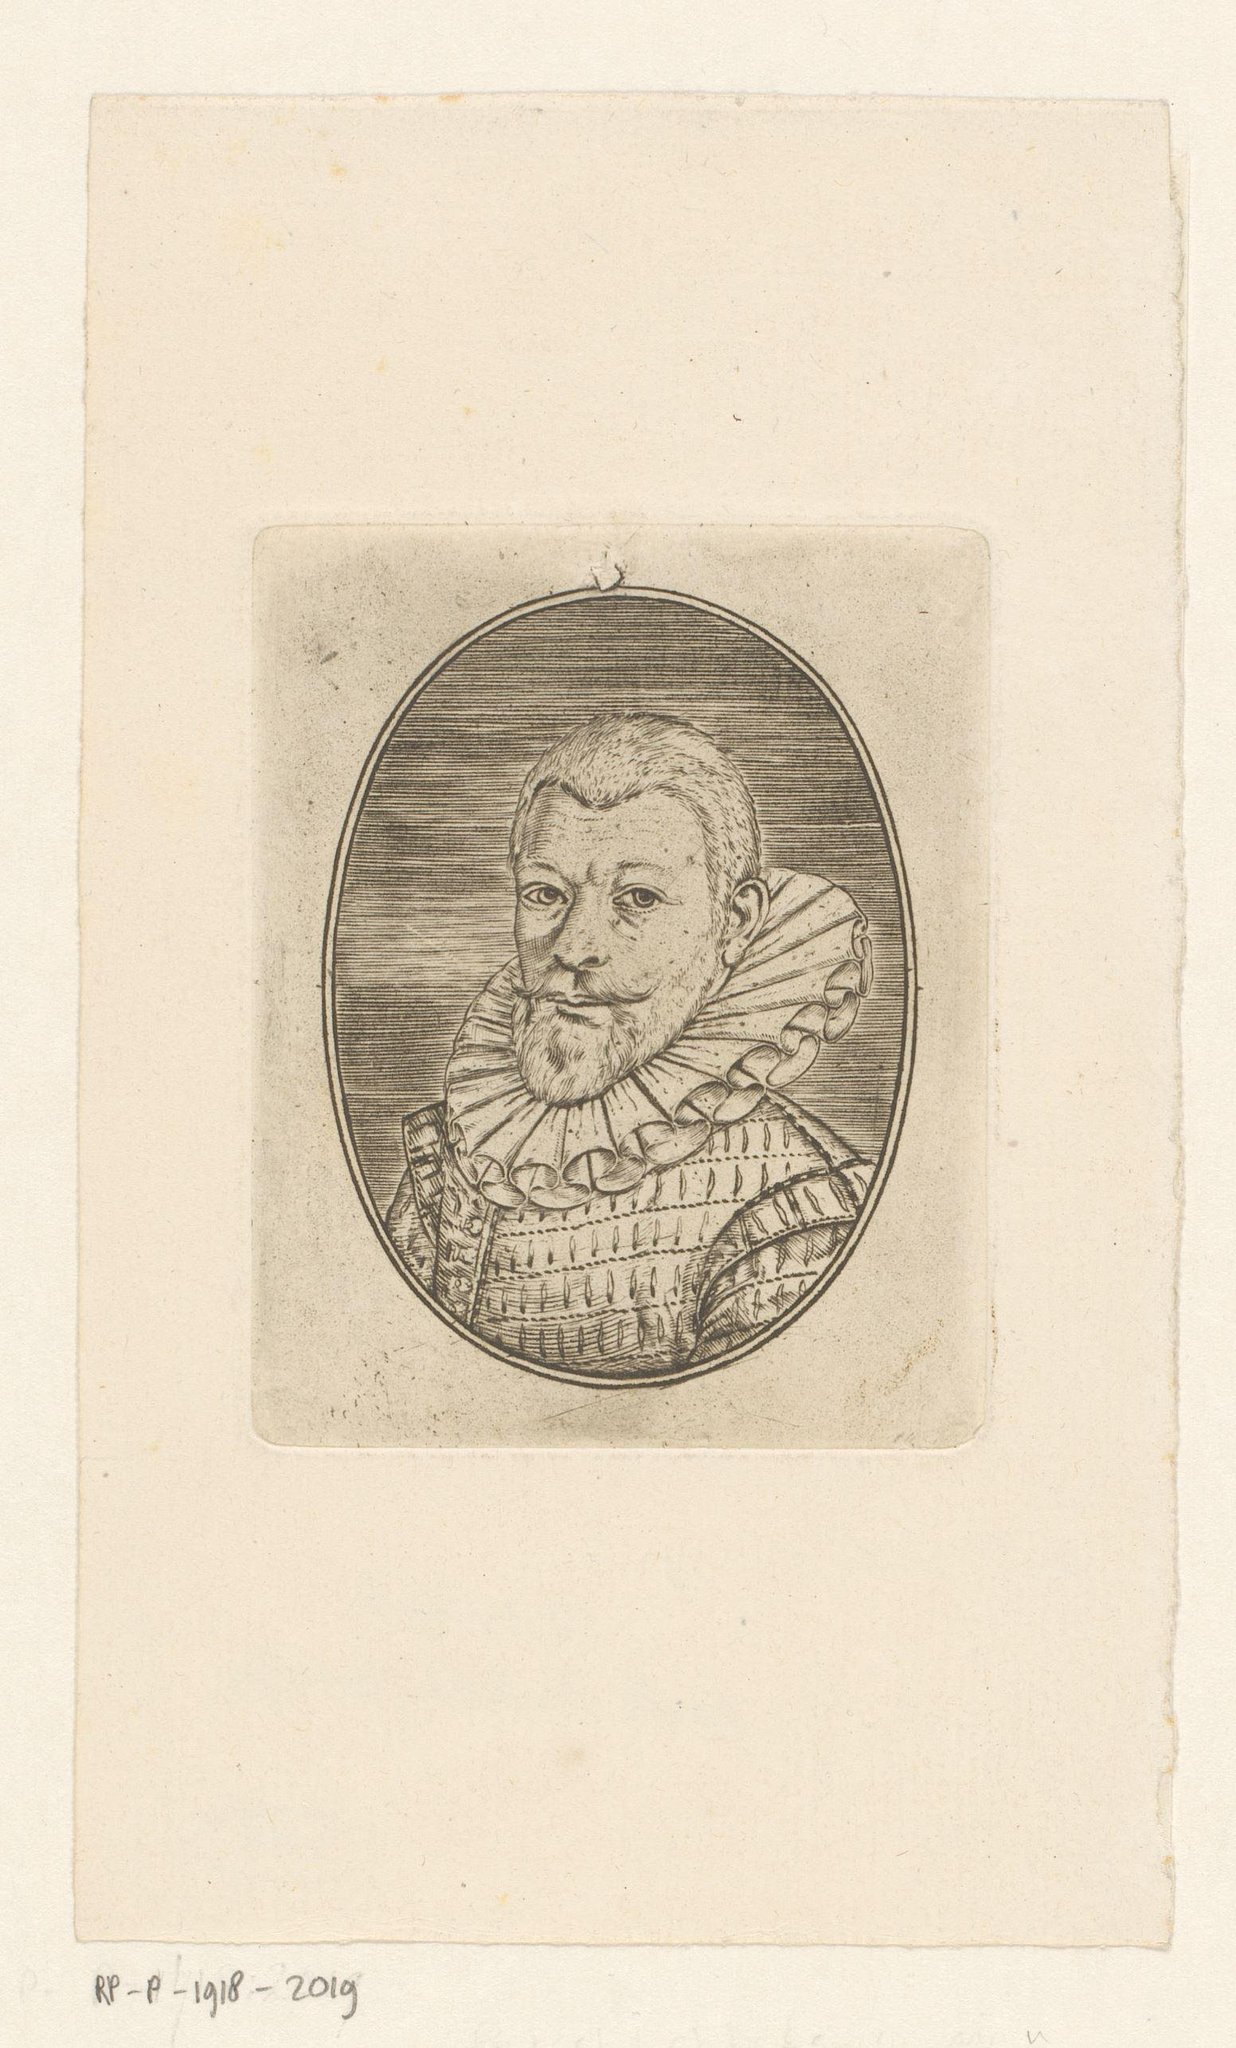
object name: print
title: Portret van een onbekende man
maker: Anonymous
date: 1600-1918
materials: paper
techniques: etching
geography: netherlands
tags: neck-gear ~ clothing, historical persons not known by name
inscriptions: collector's mark: Lugt 2233, collector's mark: Lugt 2233